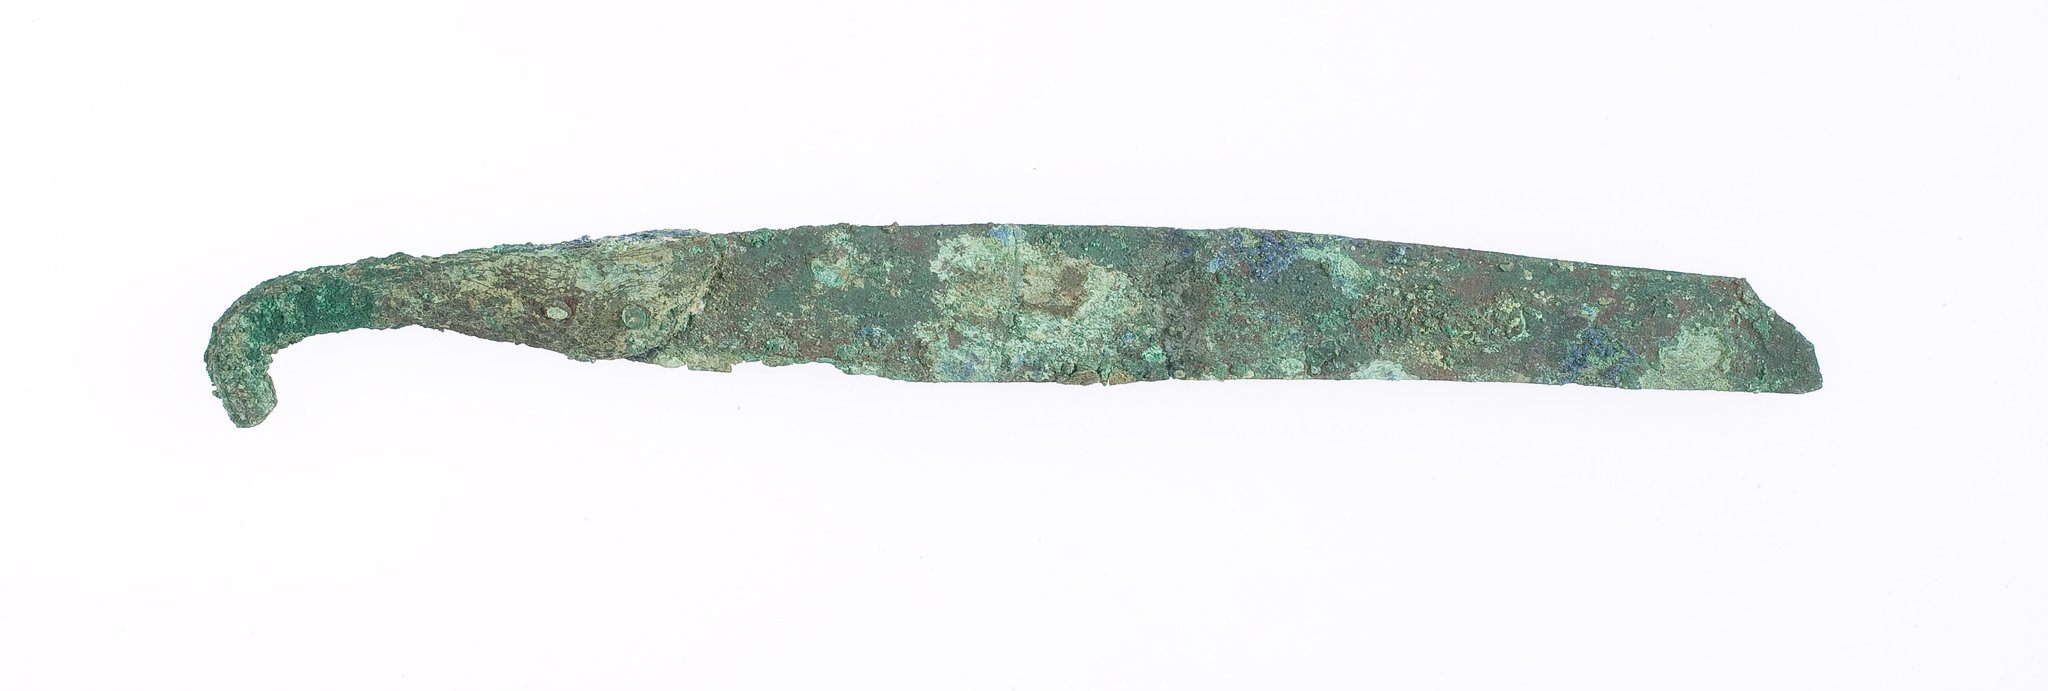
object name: knife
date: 1802-1700 BCE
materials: bronze, copper alloy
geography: egypt